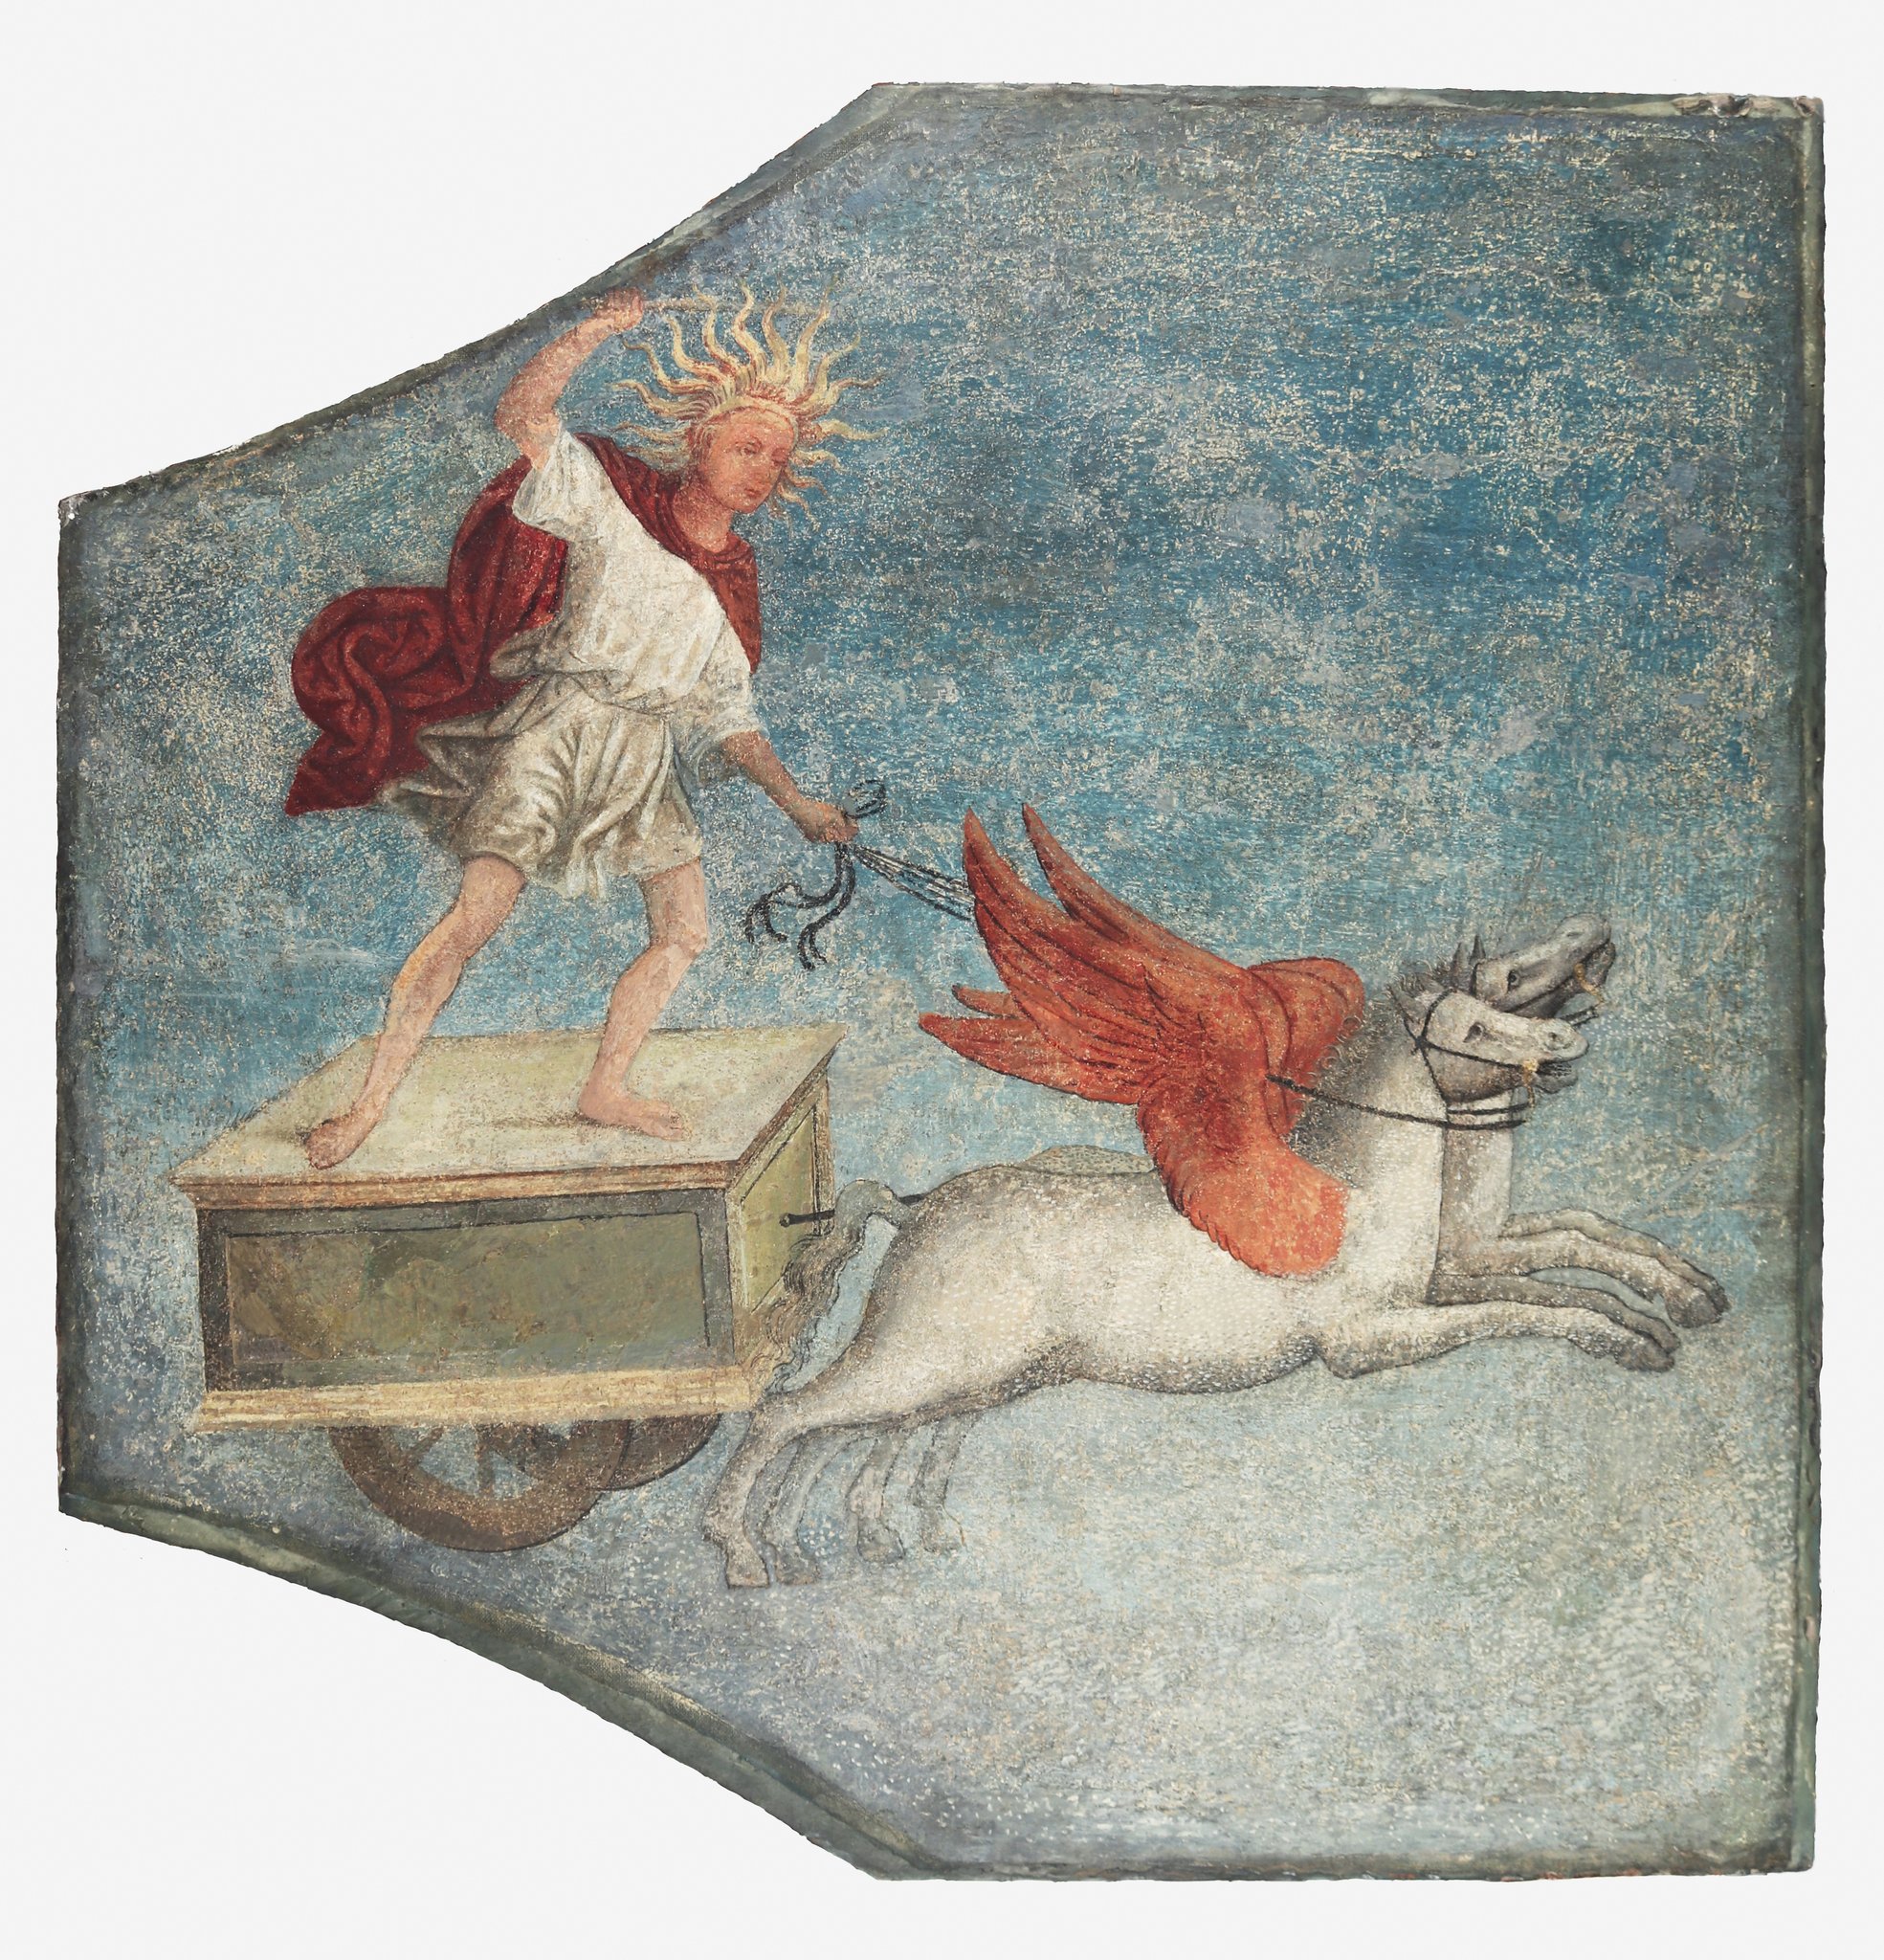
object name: ceiling panel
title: Chariot of Apollo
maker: pinturicchio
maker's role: artist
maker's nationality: italian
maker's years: 1454-1513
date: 1509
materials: canvas, panel, wood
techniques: fresco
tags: apollo,horses,chariots